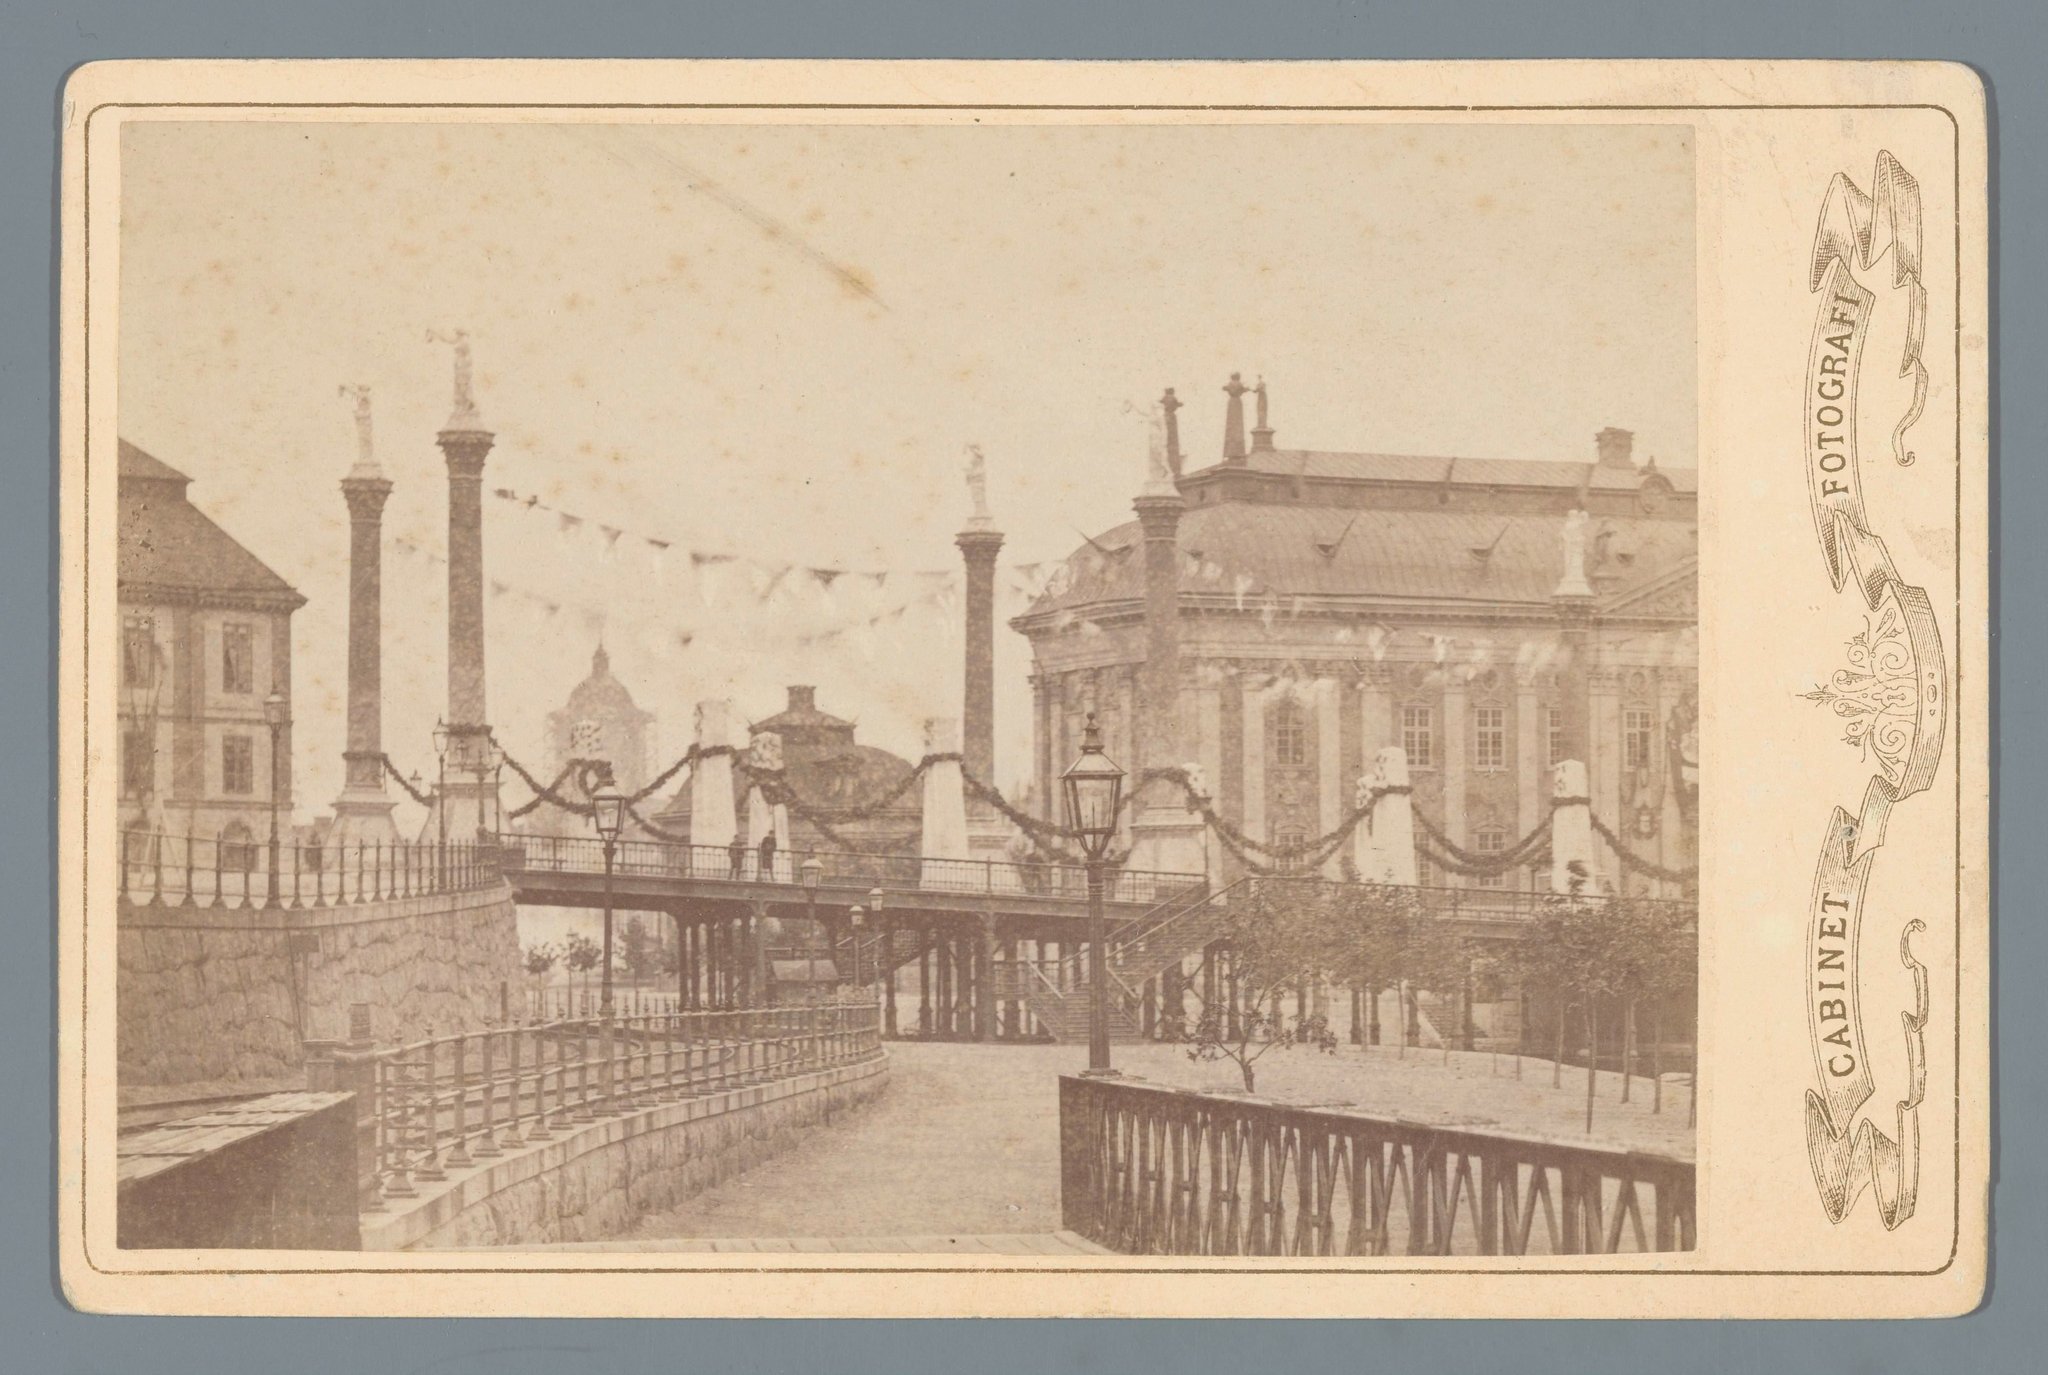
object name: cabinet photograph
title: Gezicht op straat met versieringen, vermoedelijk in Stockholm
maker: Anonymous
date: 1870-1890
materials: cardboard, photographic support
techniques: albumen print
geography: stockholm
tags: city-view, and landscape with man-made constructions, street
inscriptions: inscription: ‘Cabinet Fotografi’, inscription: ‘Stockhom’